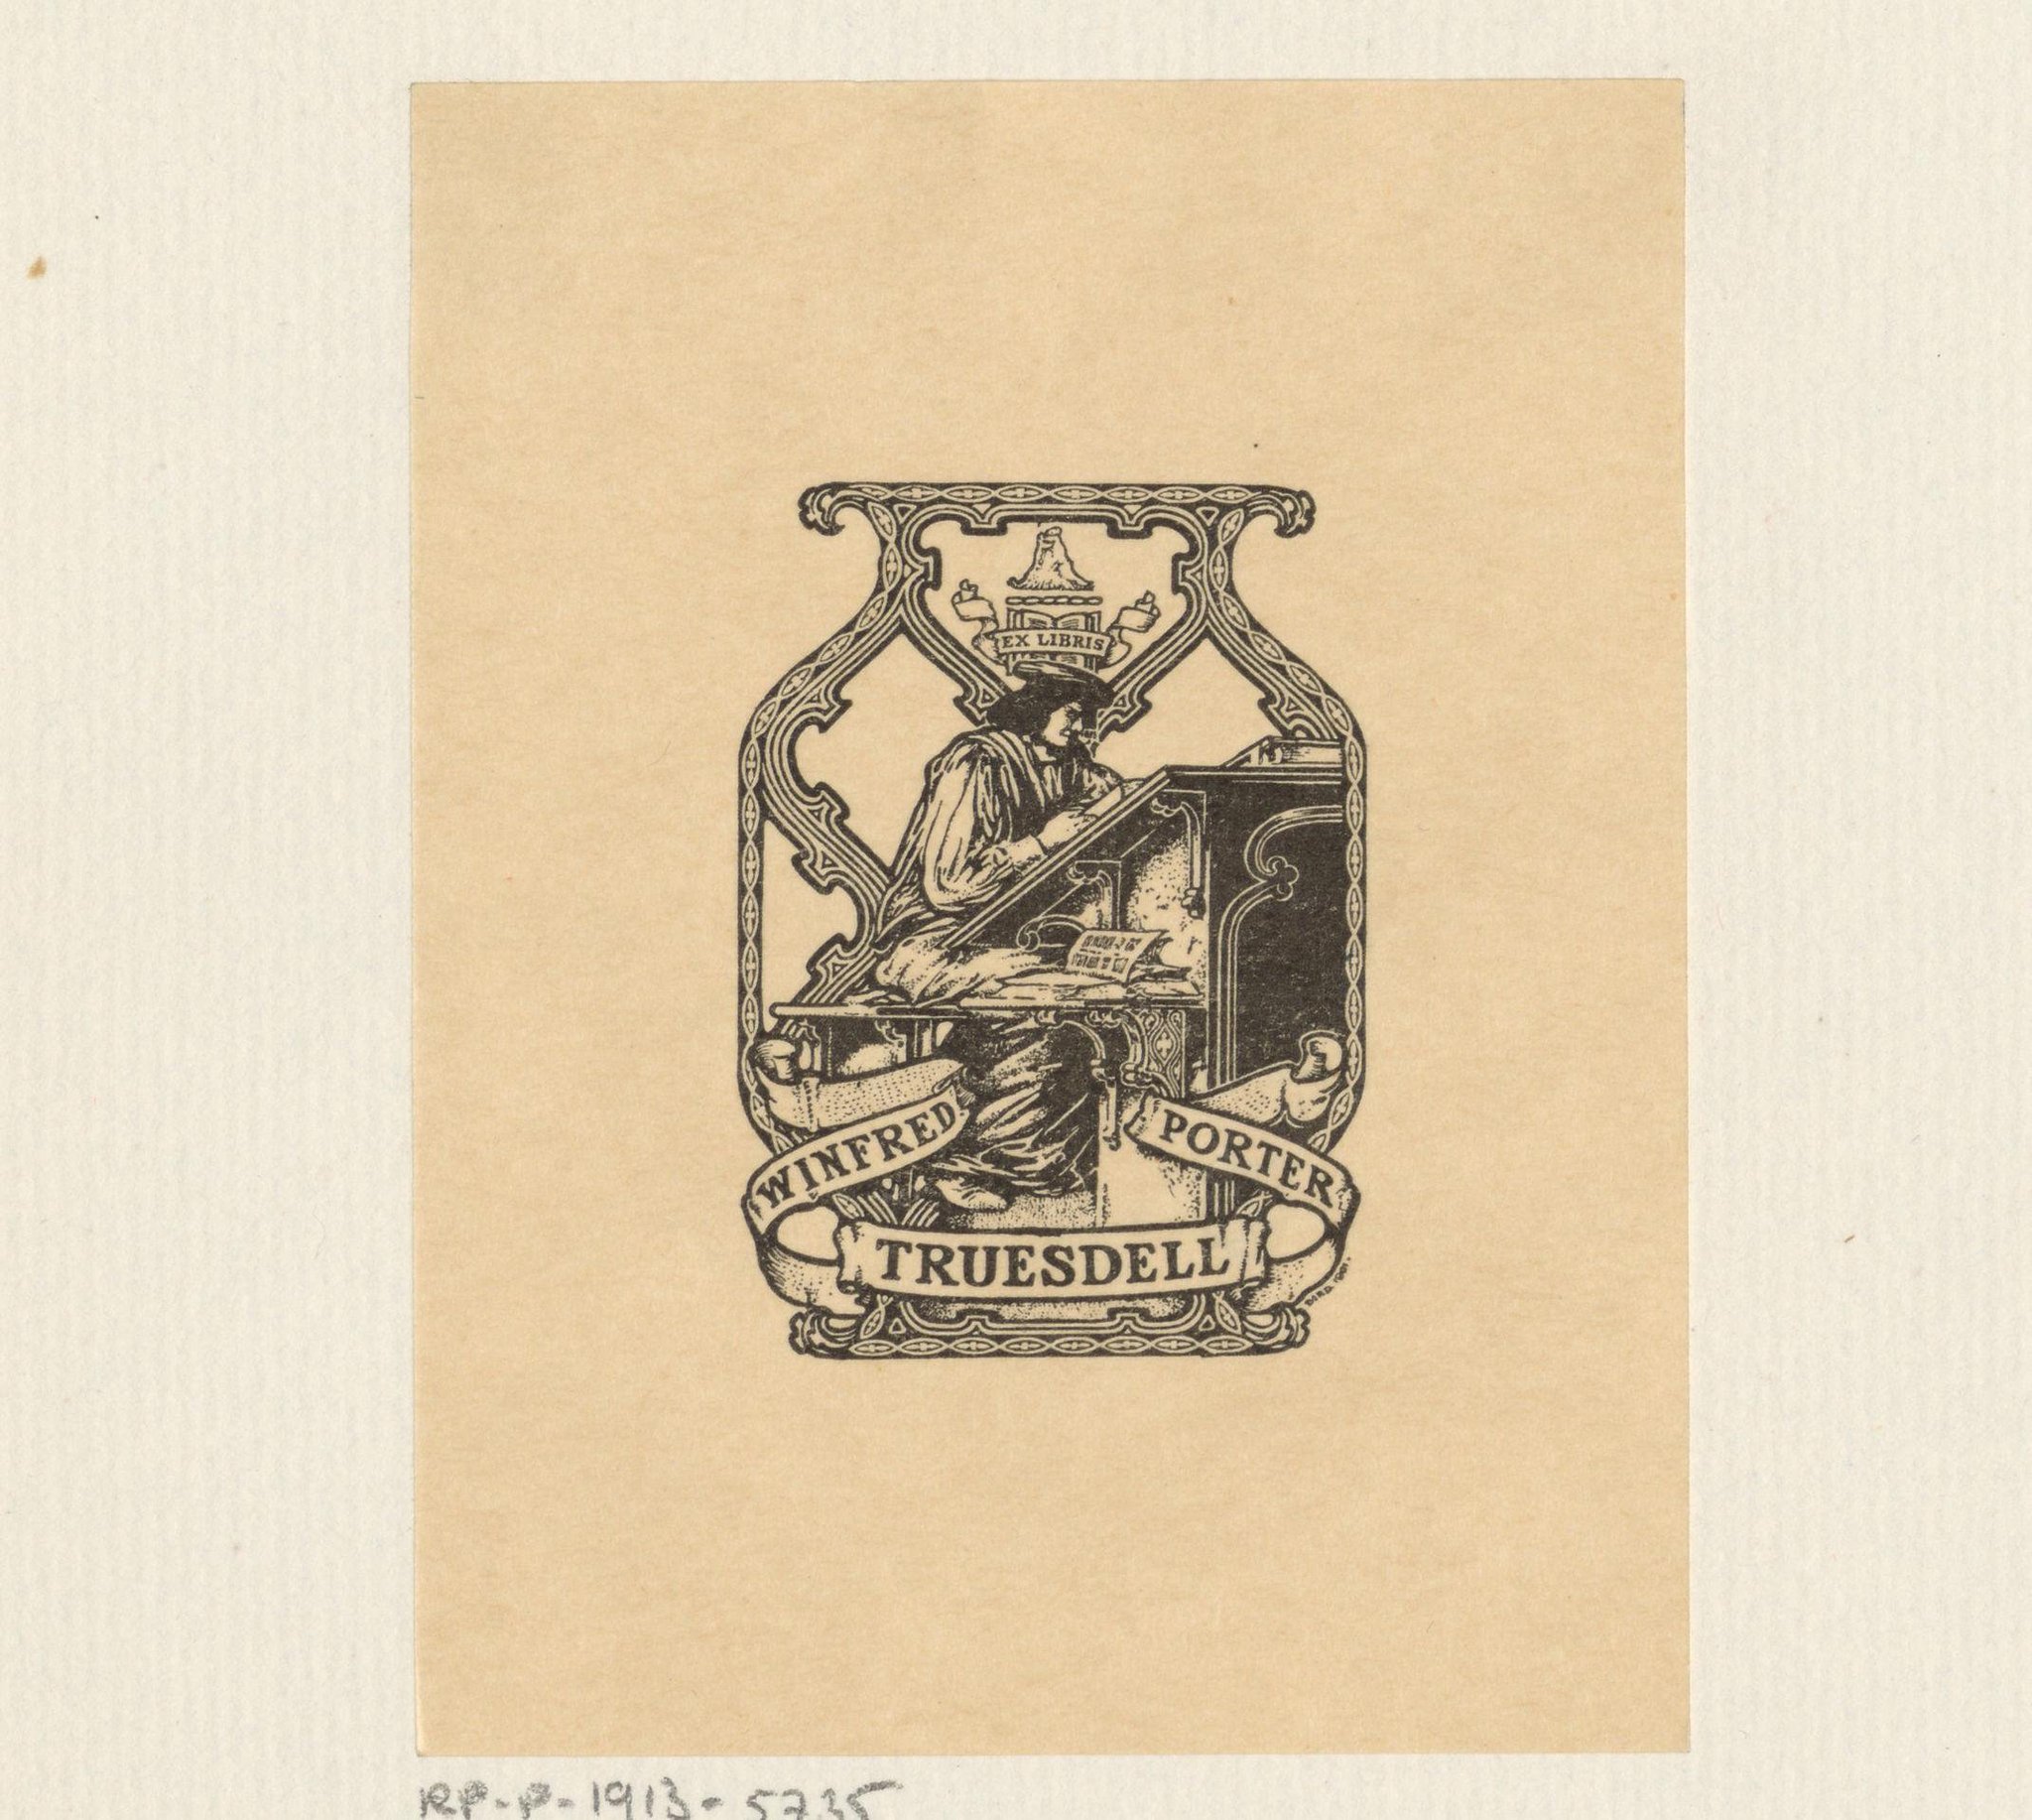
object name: bookplate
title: Ex libris van Winfred Porter Truesdell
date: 1901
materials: paper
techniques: printing block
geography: north and central america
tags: sitting figure, historical costume, book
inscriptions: collector's mark: Lugt 2233, collector's mark: Lugt 2760